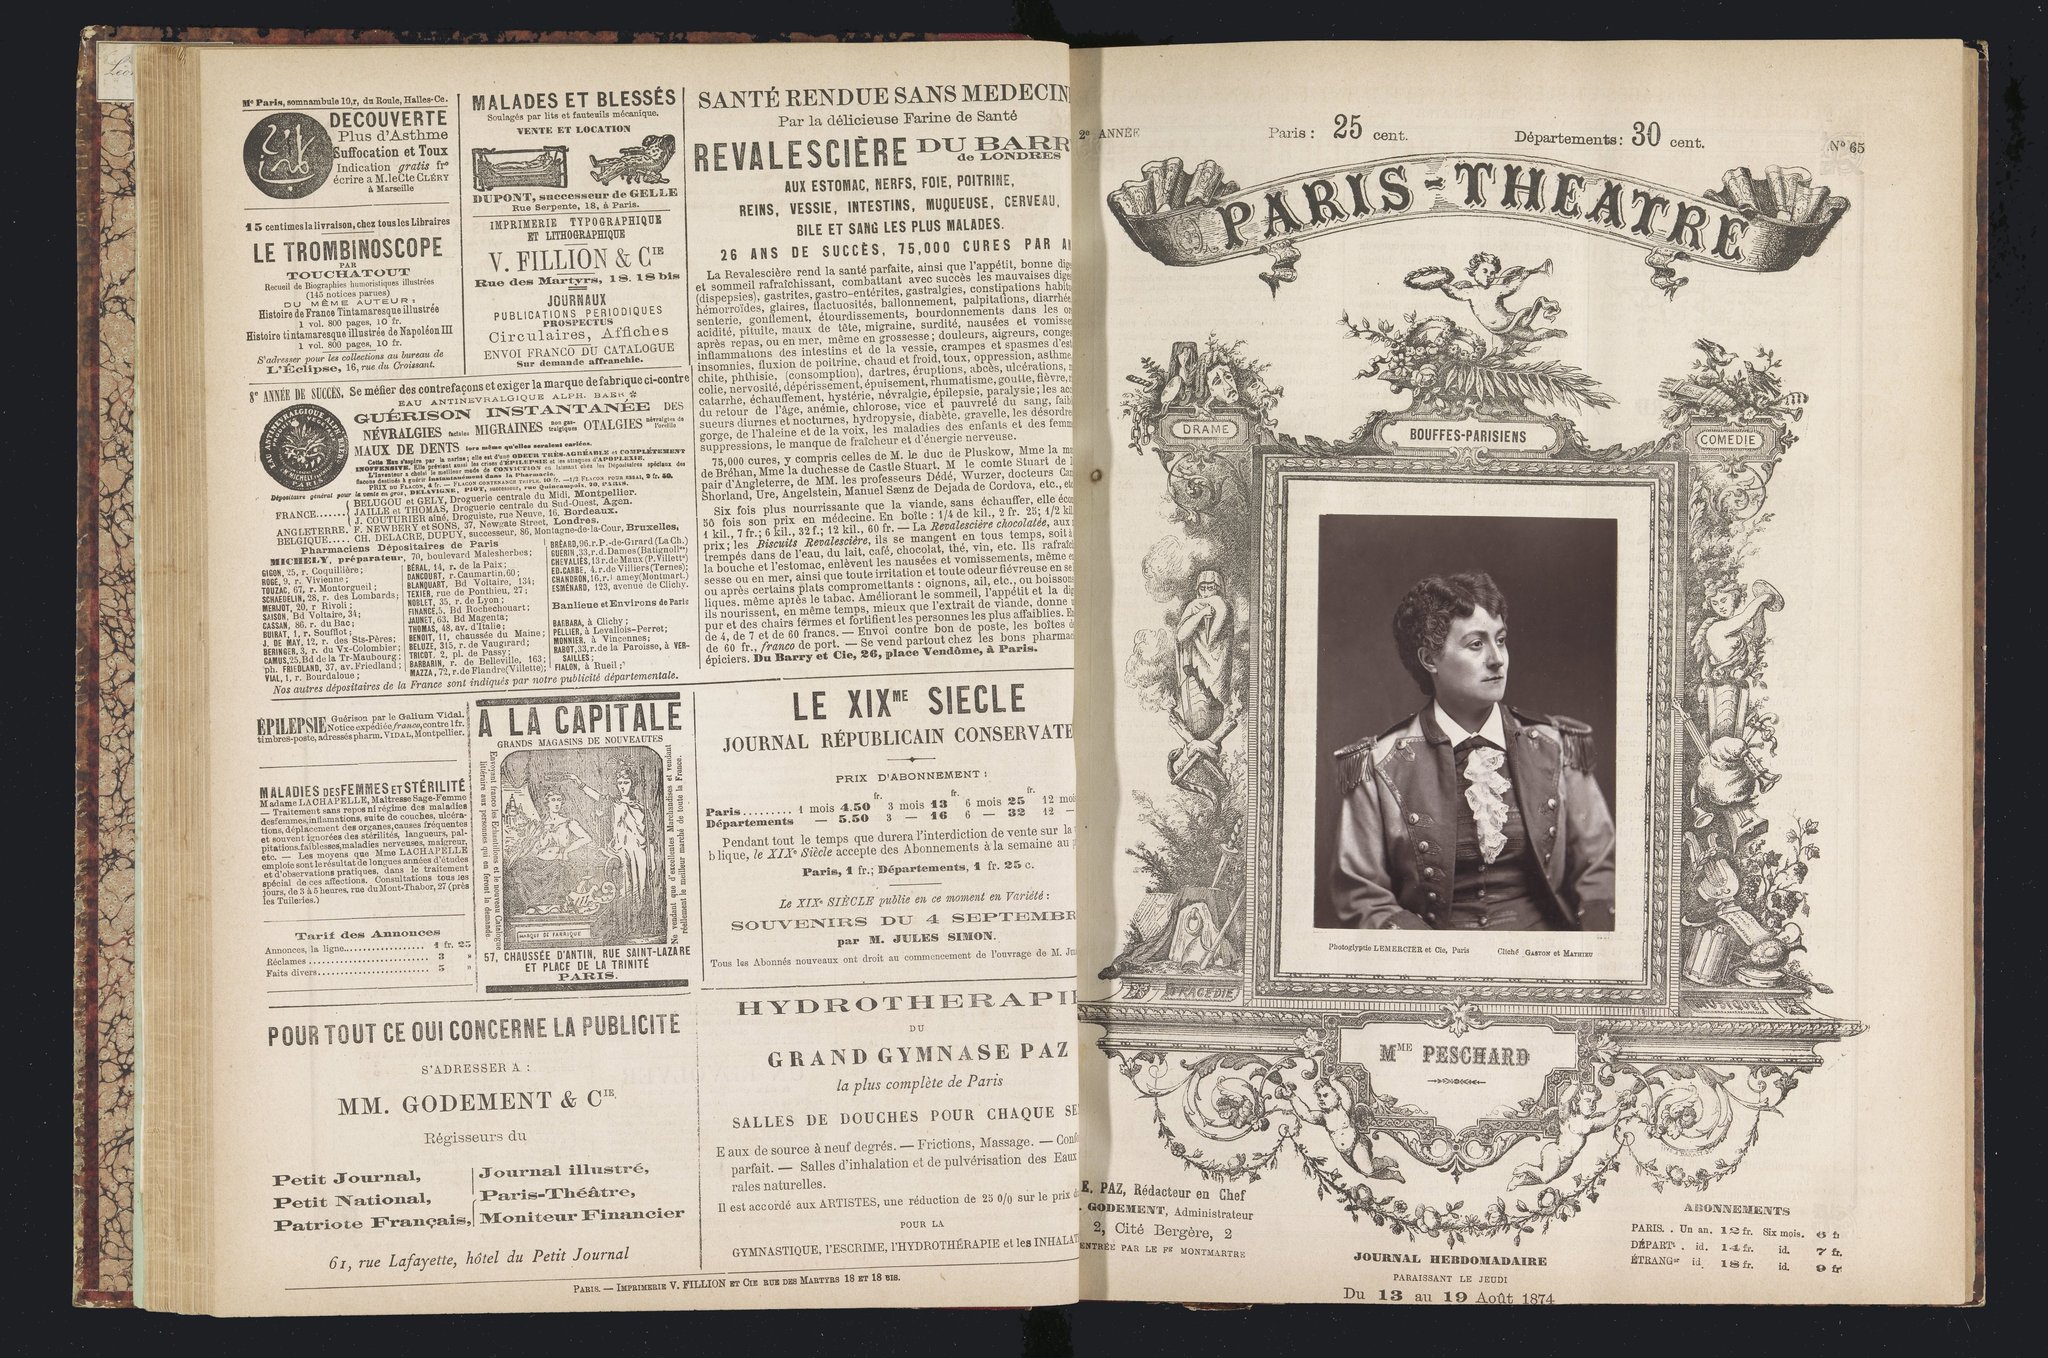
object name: page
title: Mme Peschard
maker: joseph rose lemercier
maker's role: printer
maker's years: 1803-1887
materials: paper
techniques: woodburytype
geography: france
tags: portrait of opera-singer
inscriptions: number: ‘No 65’, inscription: ‘Journal hebdomadaire paraissant le jeudi Du 13 au 19 Août 1874’